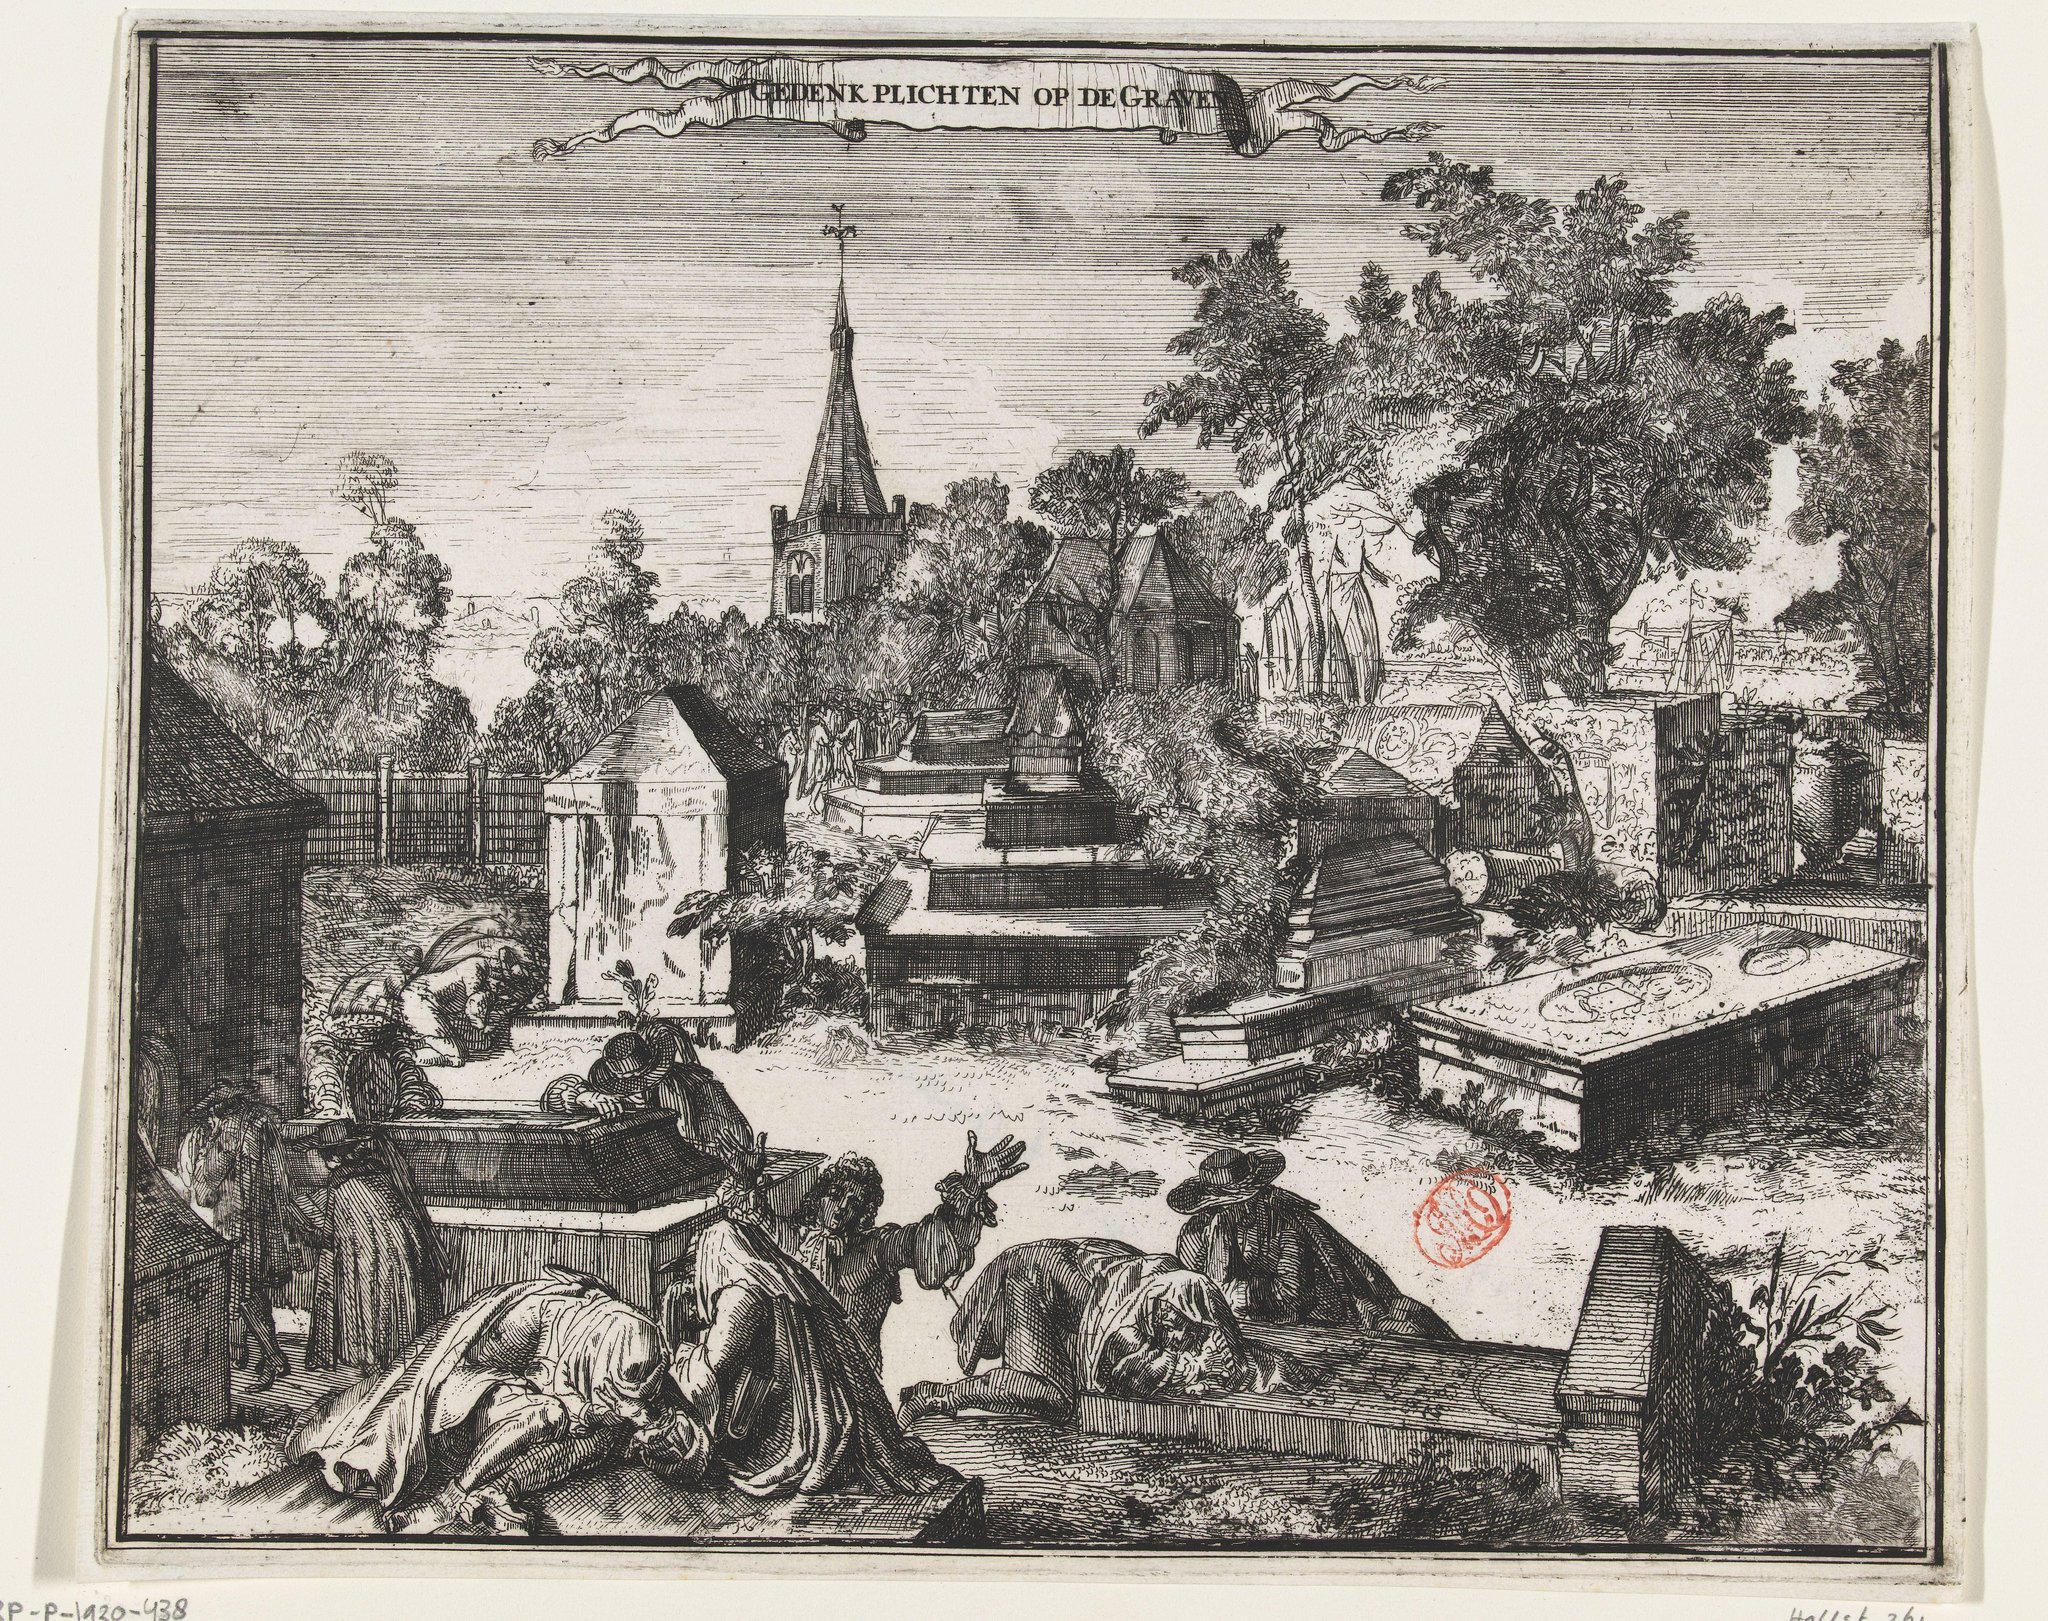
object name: print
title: Rouwende mannen op de Portugees-Joodse begraafplaats Beth Haim te Ouderkerk aan de Amstel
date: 1675-1695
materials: paper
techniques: engraving, etching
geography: northern netherlands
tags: 'sephardim' ~ jewish communities, churchyard, cemetery, death and burial ~ jewish customs, jewish mourning customs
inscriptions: collector's mark: Lugt 195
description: Mogelijk uitgegeven als onderdeel van een serie, zie RP-P-AO-8-16A, RP-P-AO-24-43-1, RP-P-AO-8-16B, RP-P-AO-24-26, RP-P-1908-178, RP-P-AO-24-30-1, RP-P-AO-24-30-2, RP-P-AO-24-31-1, RP-P-AO-24-31-2, RP-P-AO-24-39, RP-P-AO-24-74-1, RP-P-OB-5626, RP-P-AO-24-74-2, RP-P-OB-5625, RP-P-AO-24-75, RP-P-OB-5627 en RP-P-OB-67.742